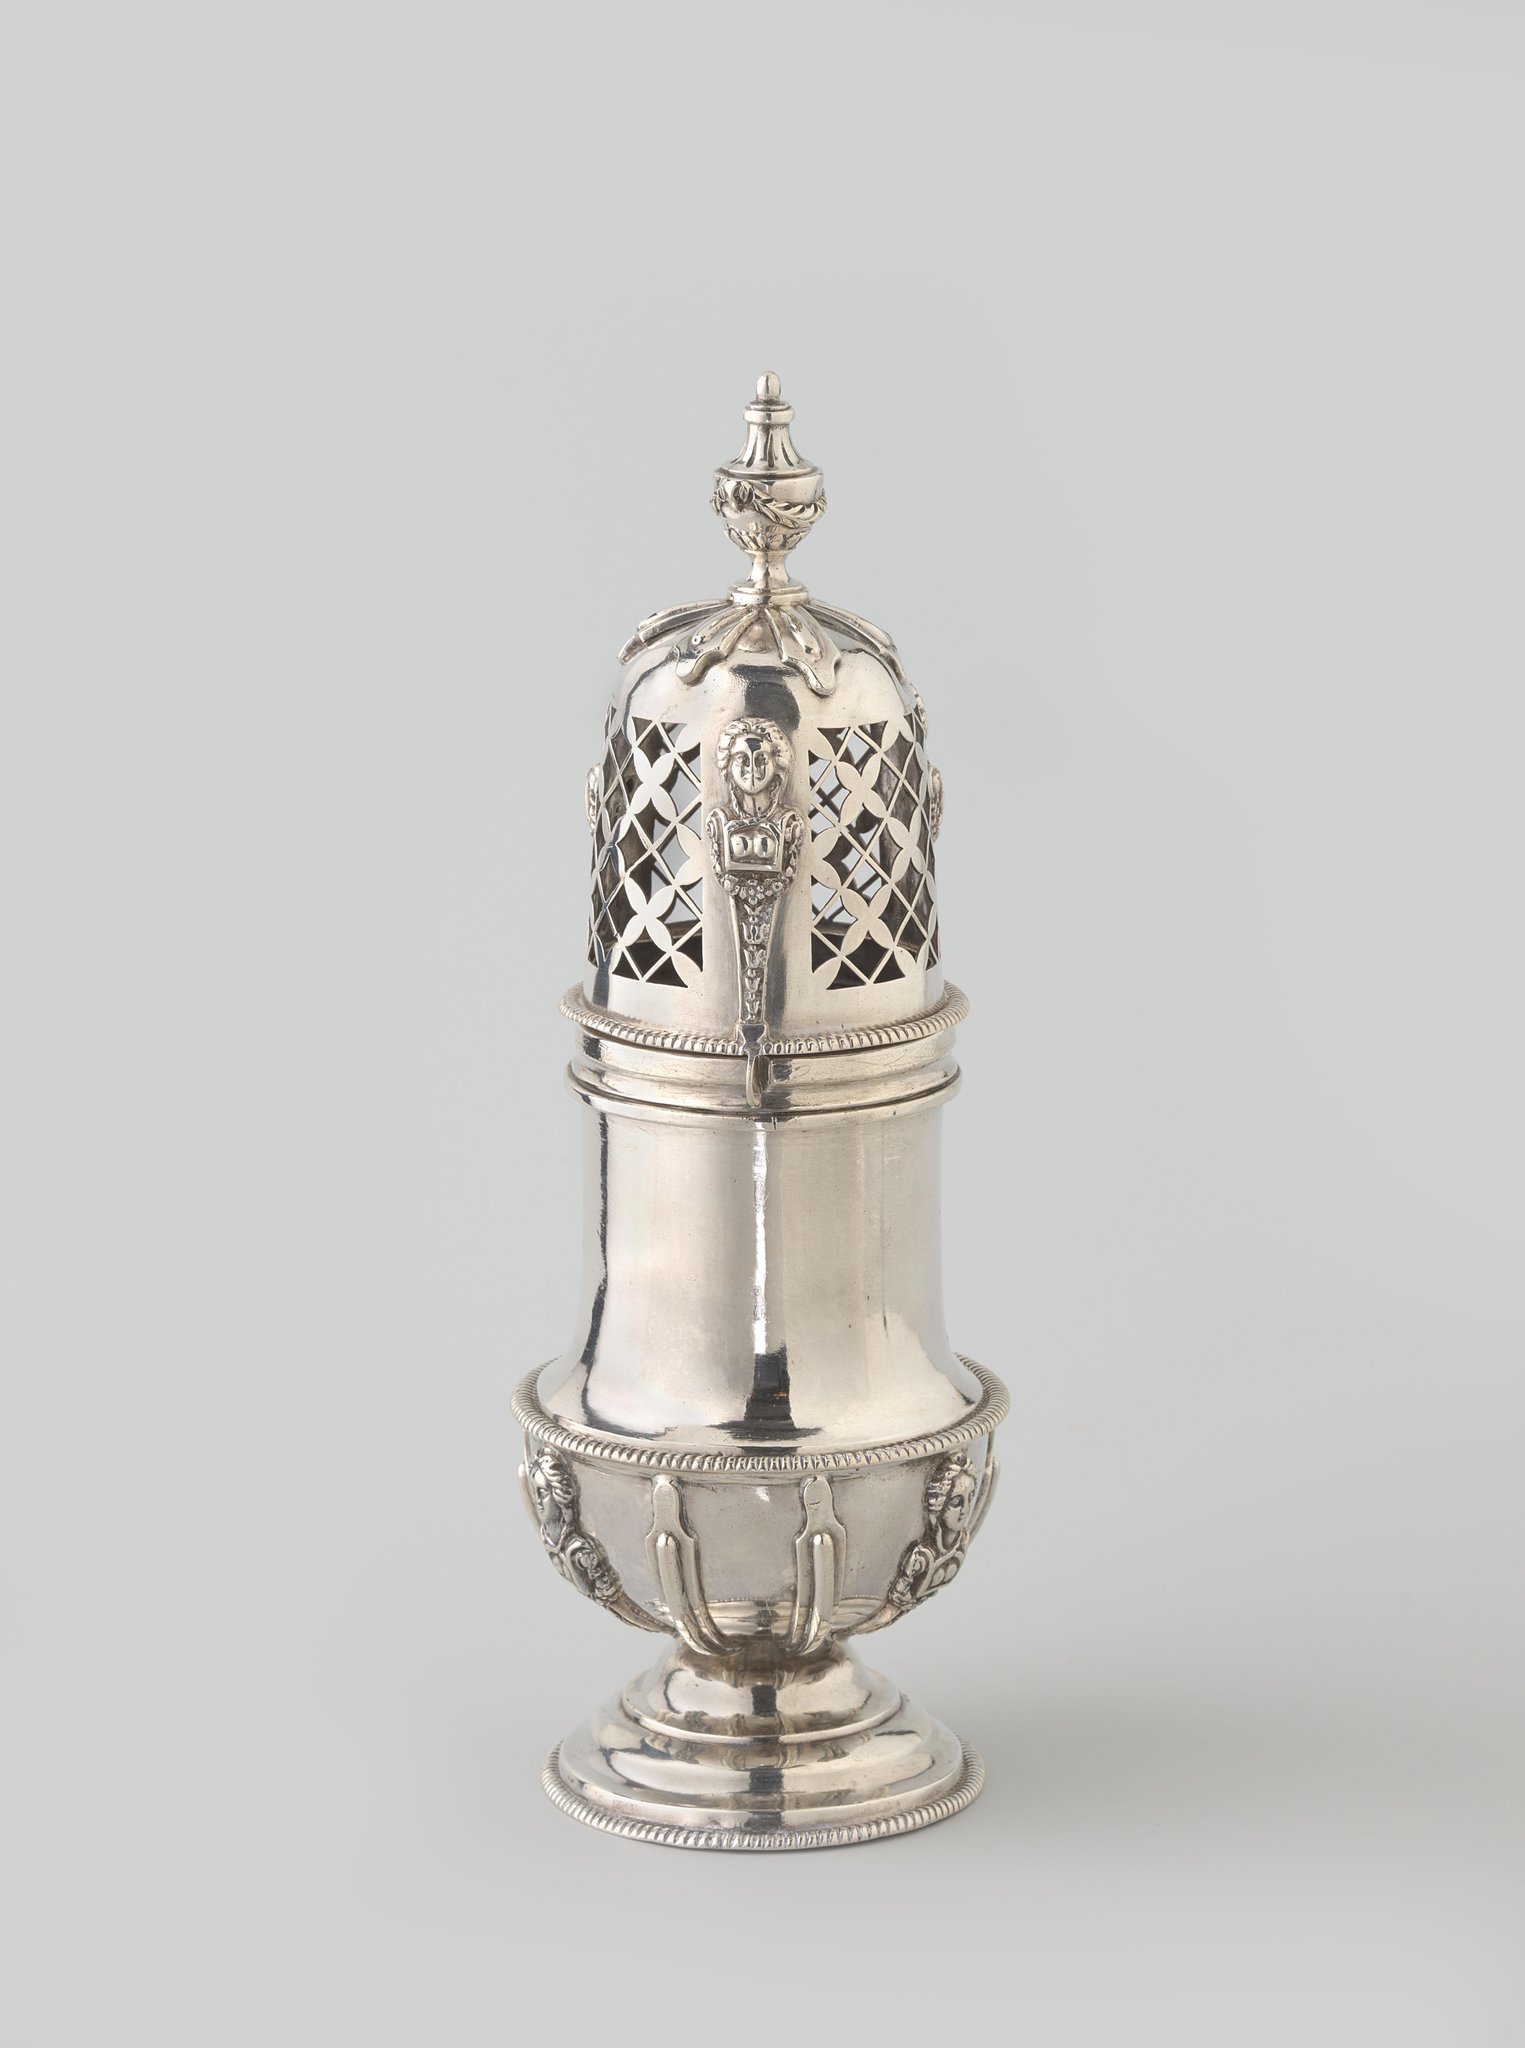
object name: forgery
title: Strooibus versierd met godrons en hermen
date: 1944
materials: silver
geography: amsterdam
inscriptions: mark (false): ‘onleesbaar gekroond’, duty mark (false), date letter (false): ‘S’, maker's mark (false)